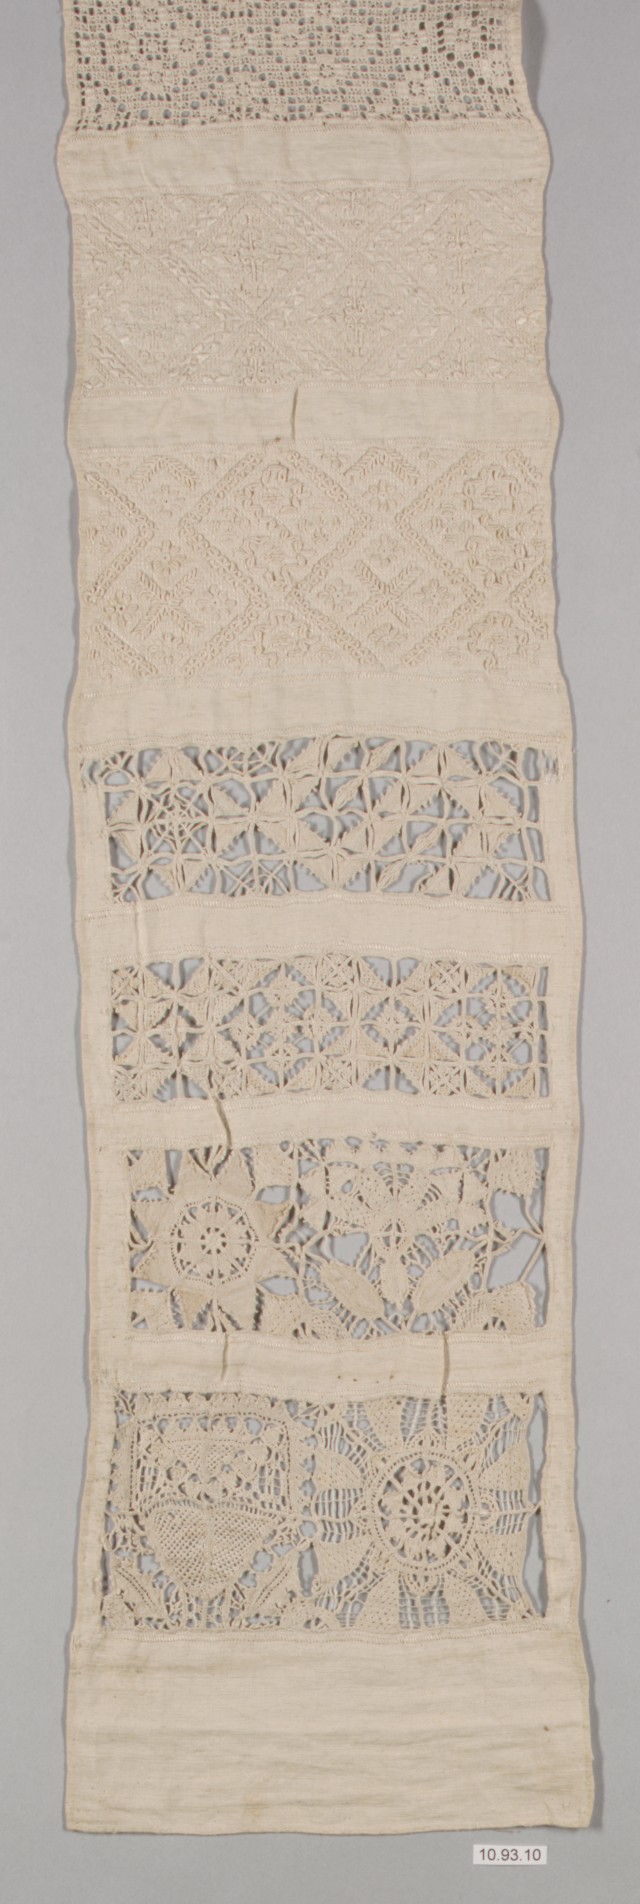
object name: sampler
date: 1701-1800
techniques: embroidery, lace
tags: flowers